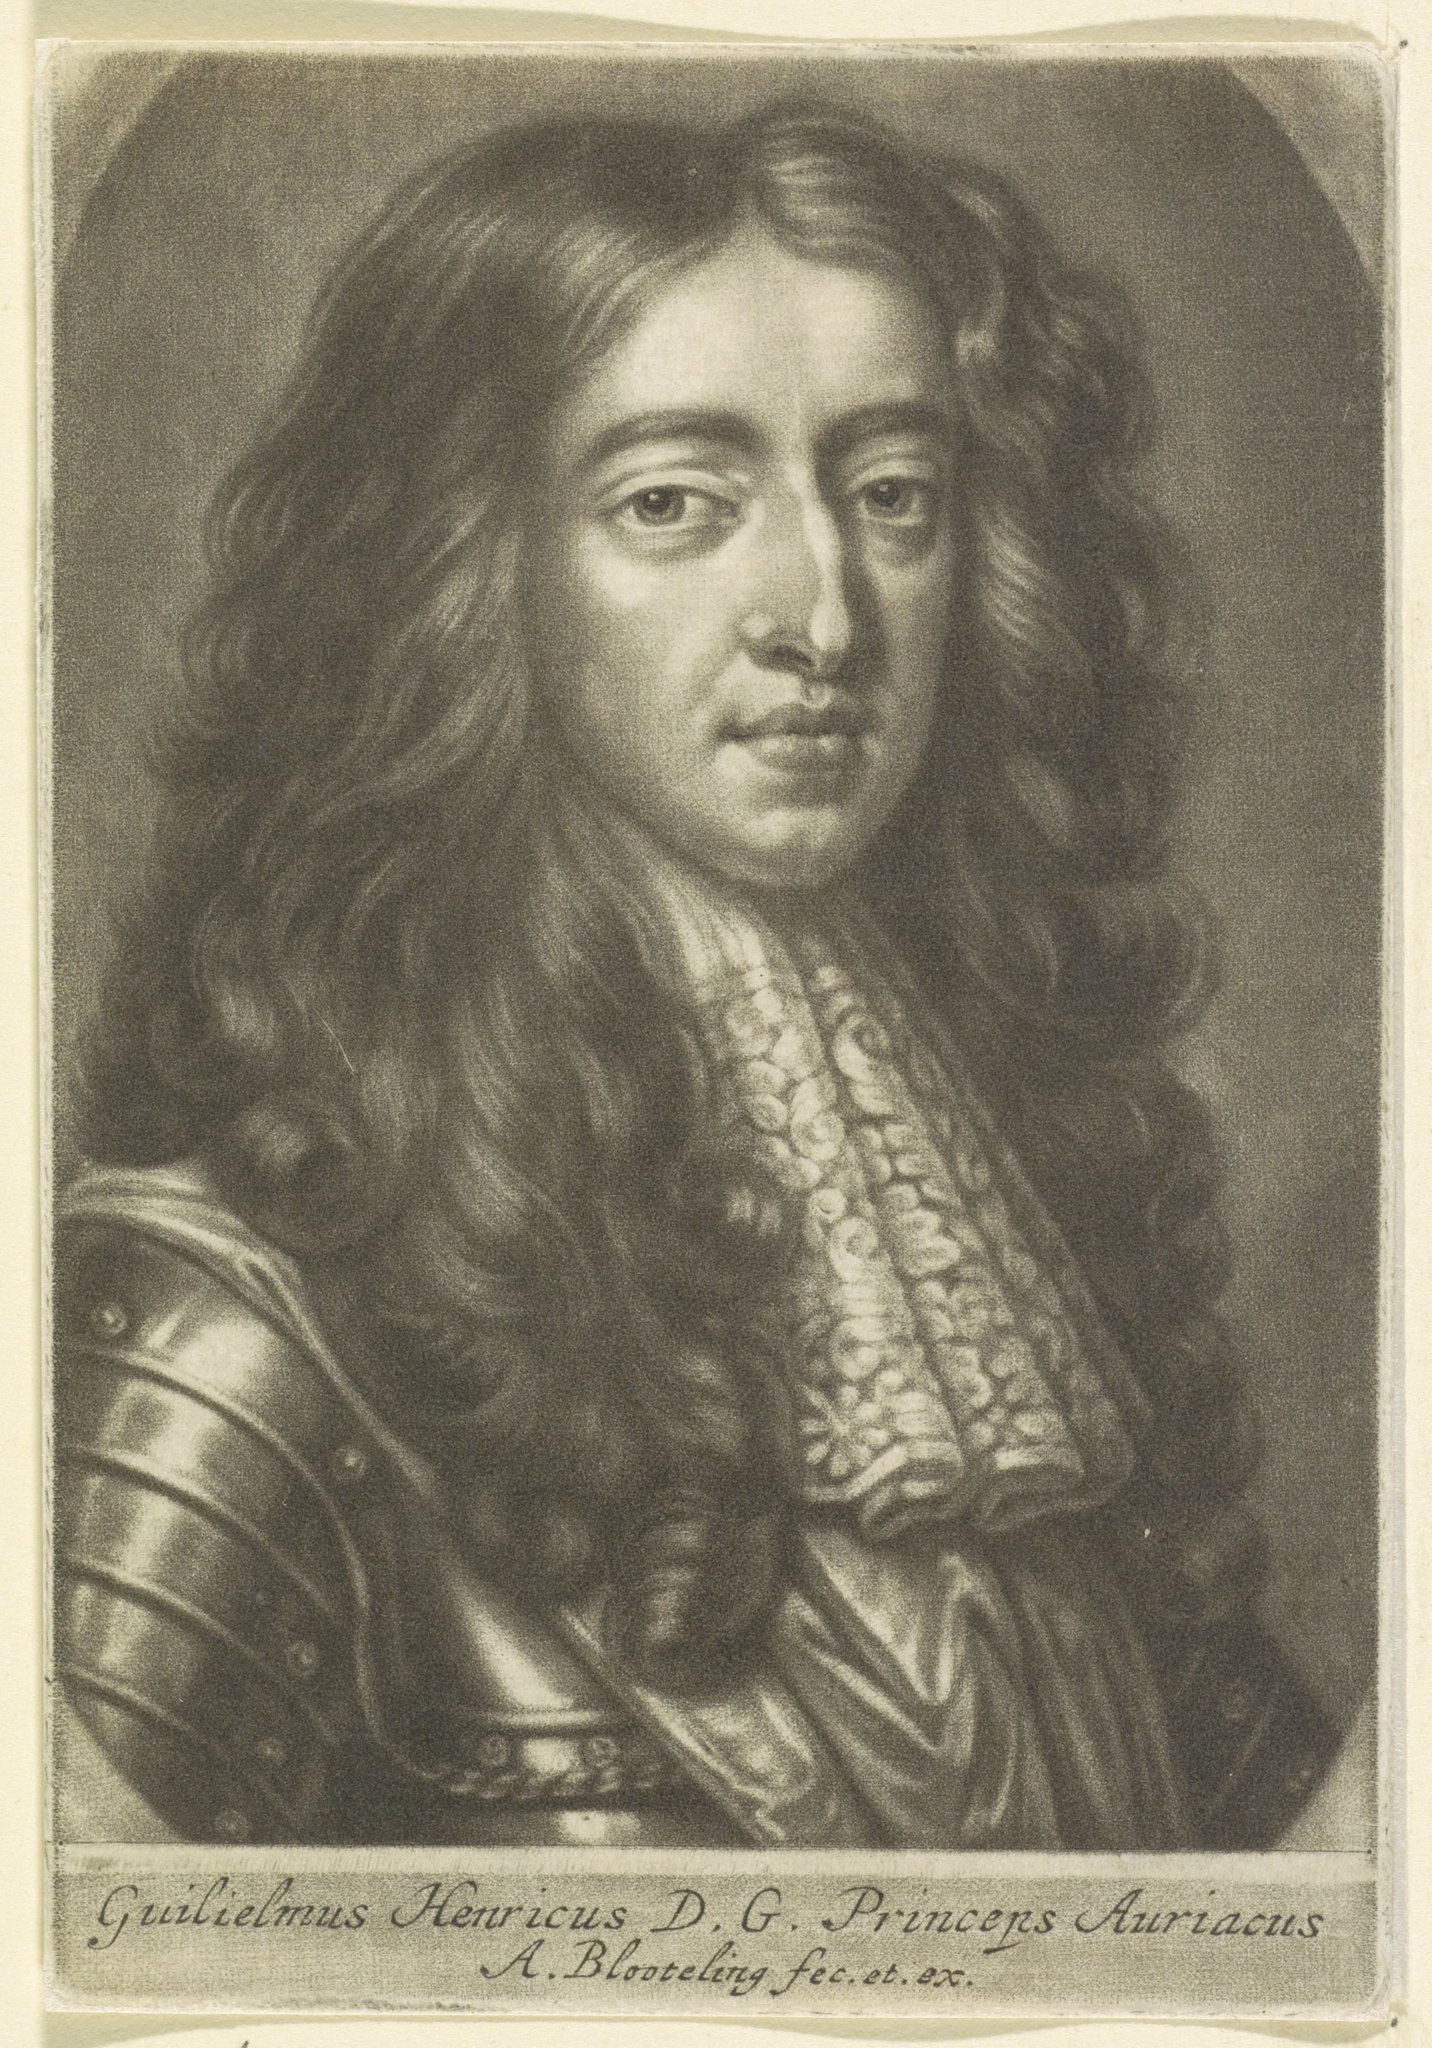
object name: print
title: Portret van Willem III, prins van Oranje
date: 1670-1690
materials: paper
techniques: mezzotint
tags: the hague, william iii (prince of orange and king of england, scotland, and ireland)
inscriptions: collector's mark: Lugt 2228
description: De hier vermelde titel verwijst naar de hoogst verkregen titel van de geportretteerde, niet per se naar de titel die de geportretteerde op deze voorstelling draagt.